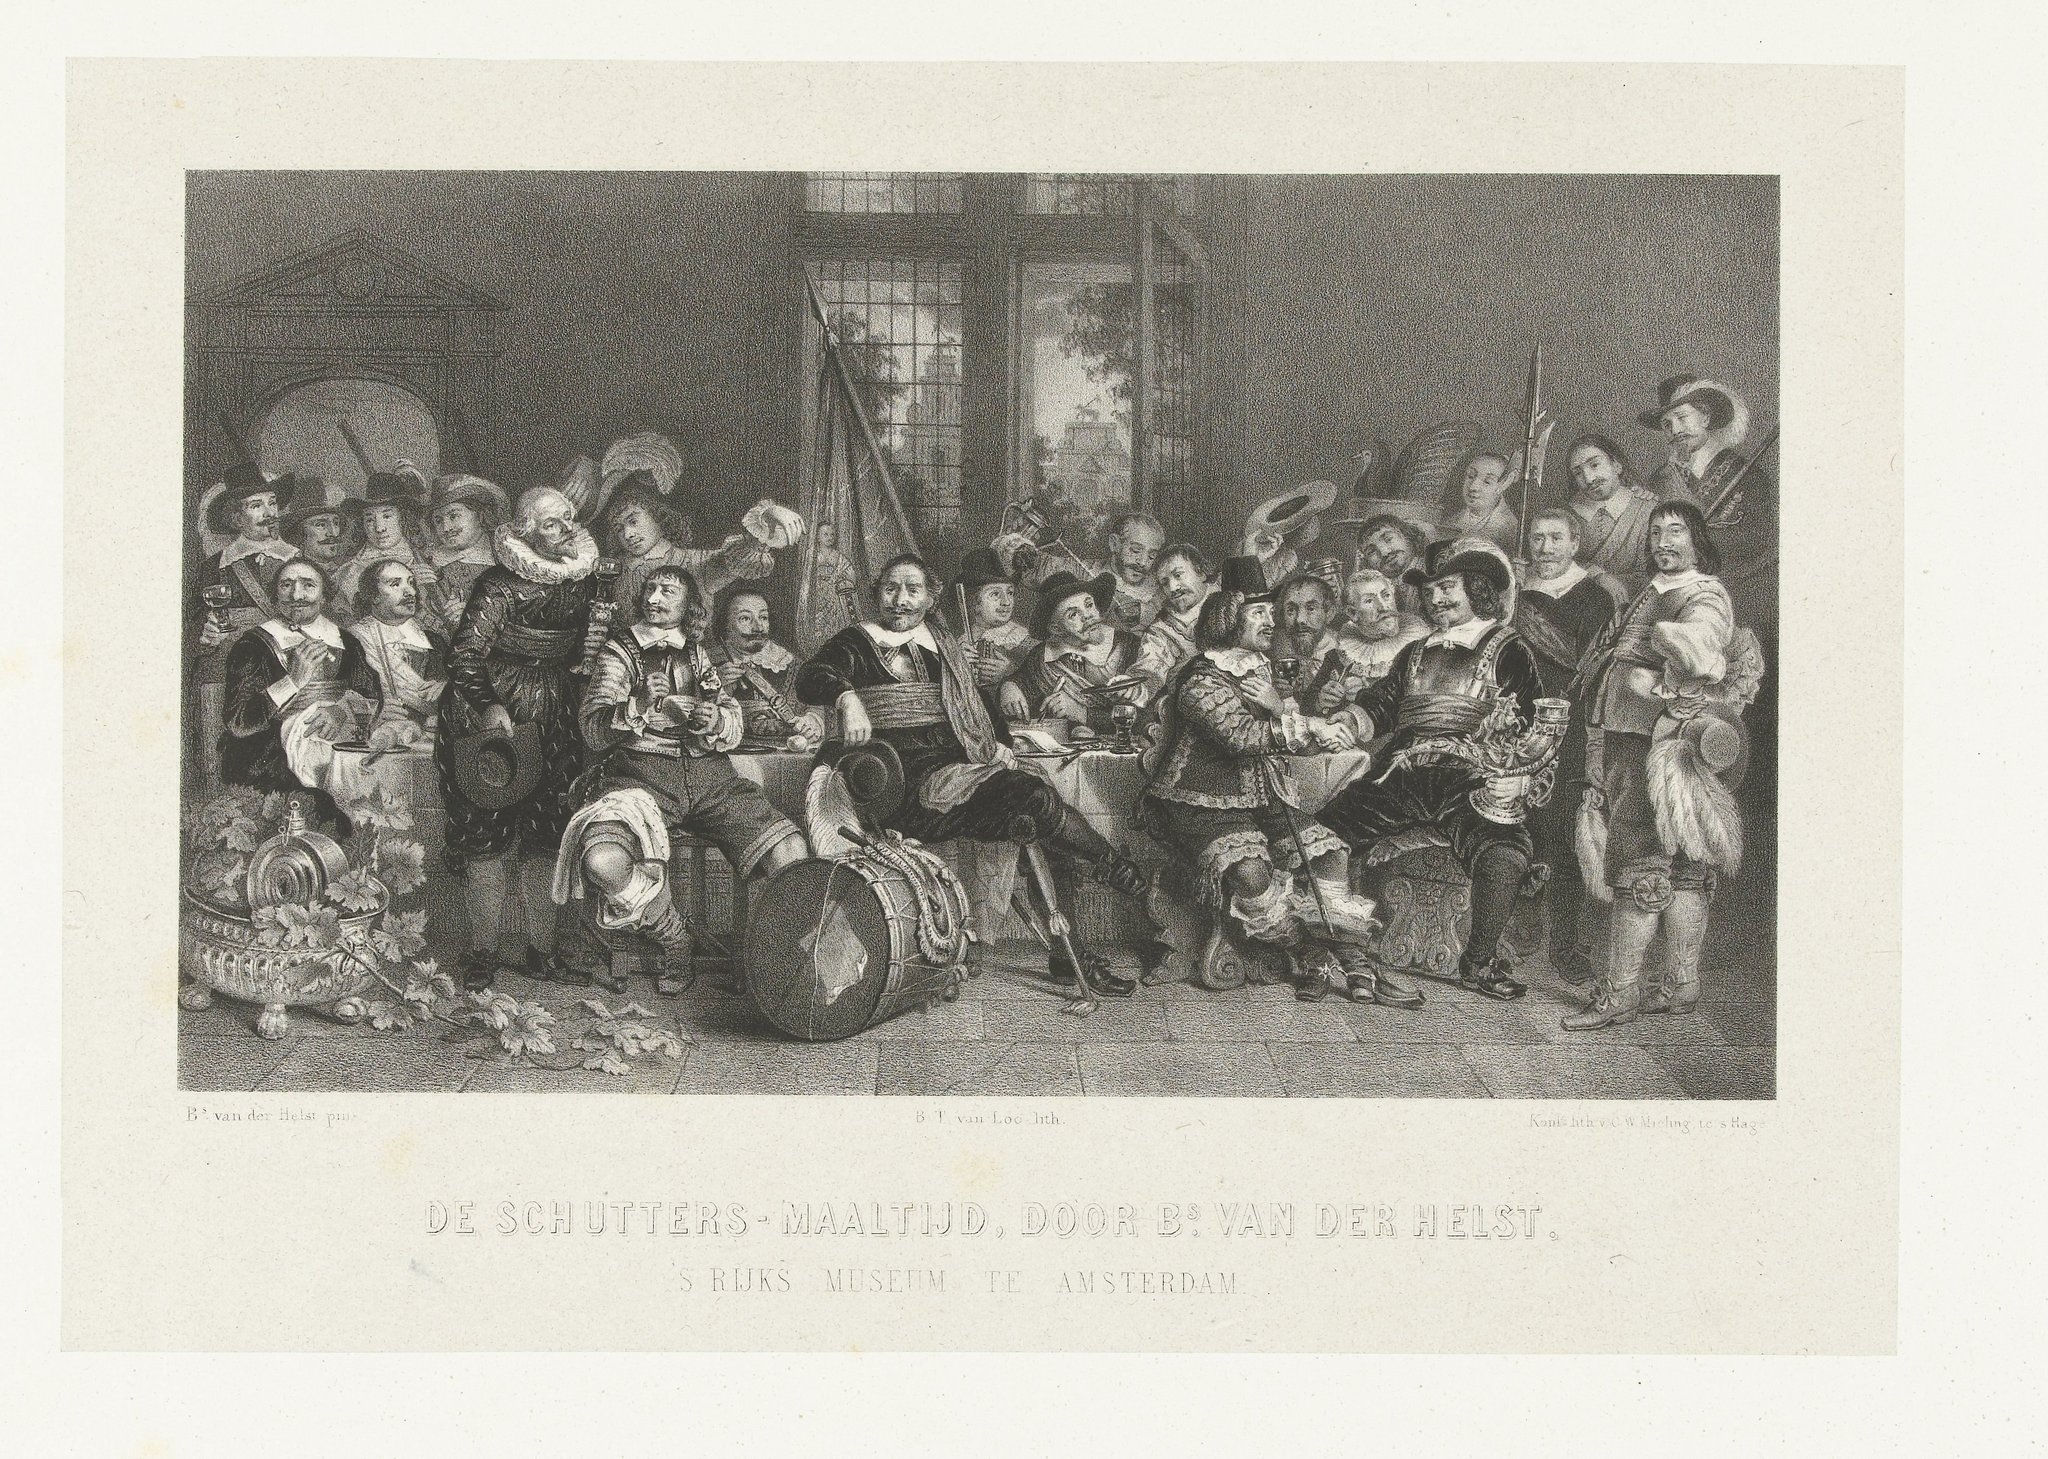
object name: print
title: De schuttersmaaltijd in de Voetboogdoelen of St. Jorisdoelen te Amsterdam ter viering van het sluiten van de vrede van Munster, 18 juni 1648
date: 1826-1892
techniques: printmaking, lithograph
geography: netherlands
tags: warfare; military affairs (+ citizen soldiery, civil guard, citizen militia), celebration meal, feast, banquet, festivities on events of national importance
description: De schuttersmaaltijd in de Voetboogdoelen of St. Jorisdoelen te Amsterdam ter viering van het sluiten van de vrede van Munster, 18 juni 1648. Voorgesteld zijn: kapitein Cornelis Jansz Witsen (met de zilveren drinkhoorn), luitenant Johan Oetgens van Waveren (die zijn hand schudt), de vaandrig Jacob Banningh (zittend naast de grote trommel), Dirck Claesz Thoveling en Thomas Hartog (sergeanten), Pieter van Hoorn, Willem Pietersz van der Voort, Adriaen Dirck Sparwer, Hendrick Calaber, Govert van der Mij, Johannes Calaber, Benedictus Schaeck, Jan Maes, Jacob van Diemen, Jan van Ommeren, Isaac Ooyens, Gerrit Pietersz van Anstenraadt, Herman Teunisz de Kluyter, Andries van Anstenraadt, Christoffel Poock, Hendrick Dommer Wz, Paulus Hennekijn, Lambregt van den Bos en Willem (de trommelslager). Op de grote trommel hangt een papier met een gedicht van Jan Vos. Door de openstaande ramen is de gevel van de brouwerij 'het Lam' aan de Singel zichtbaar. Rechts brengt een vrouw een kalkoenpastei binnen. Op tafel staan tinnen borden, roemers en andere glazen. Links staat op de vloer een grote metalen koeler met een wijnvat.